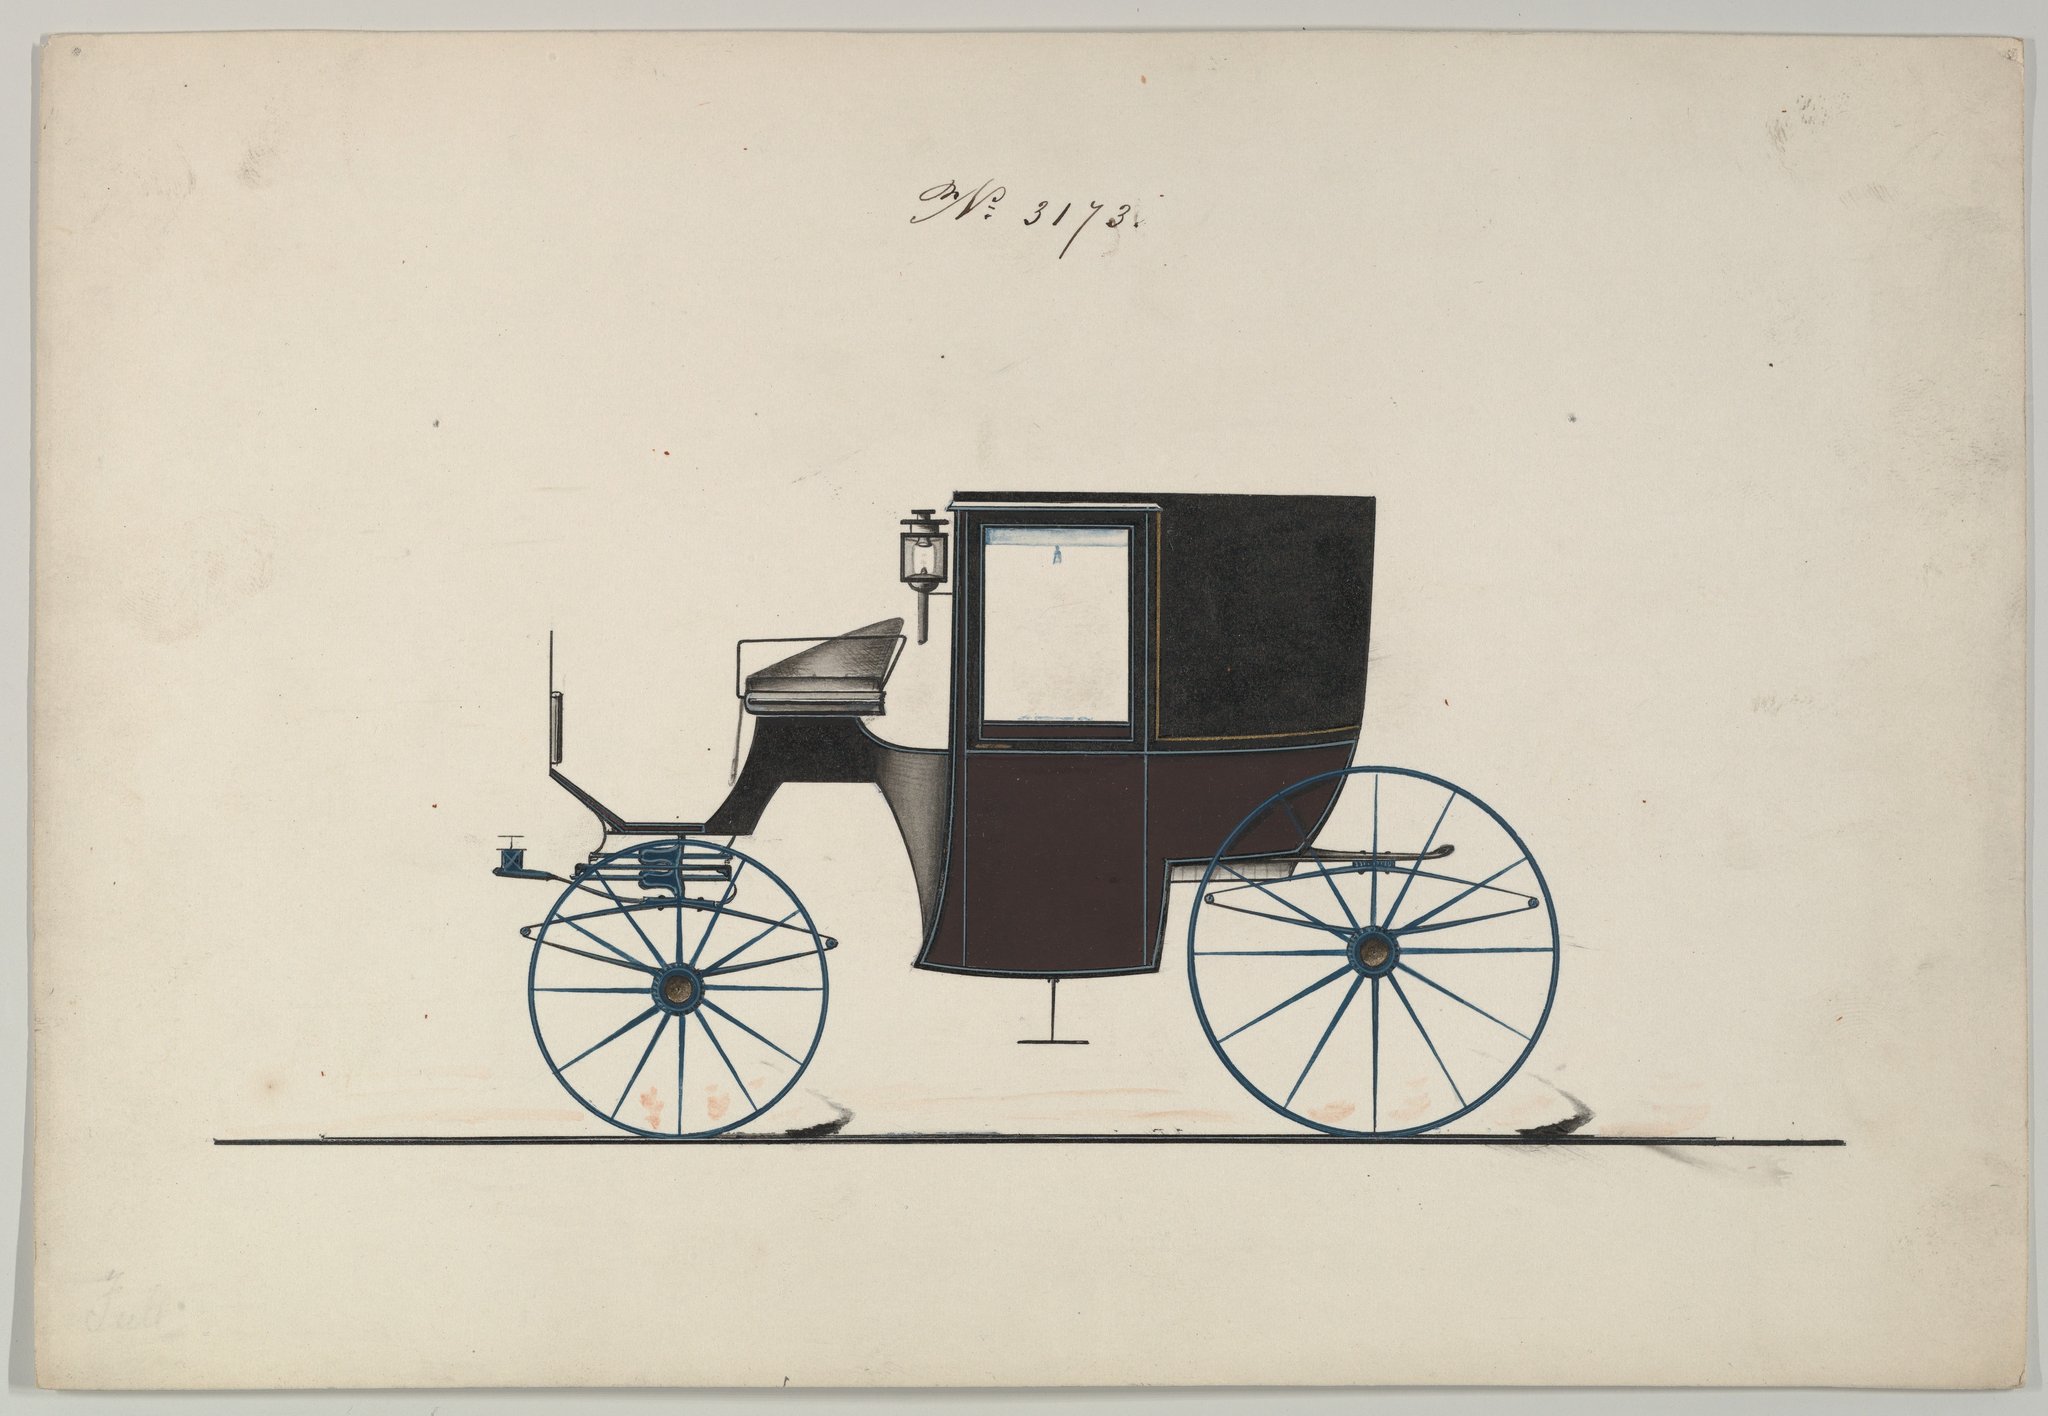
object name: drawing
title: Brougham #3173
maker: brewster & co.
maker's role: manufacturer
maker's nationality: american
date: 1875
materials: gouache, ink, watercolor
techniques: pen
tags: carriages